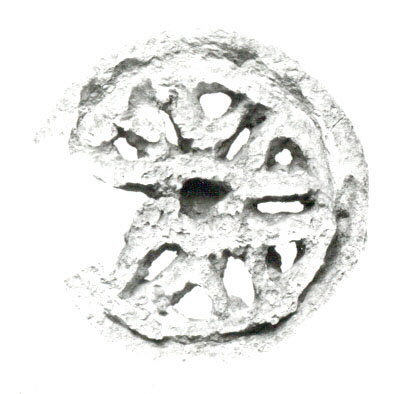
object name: stamp seal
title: Compartmented stamp seal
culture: bactria-margiana archaeological complex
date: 2333-1668 BCE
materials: copper alloy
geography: bactria-margiana